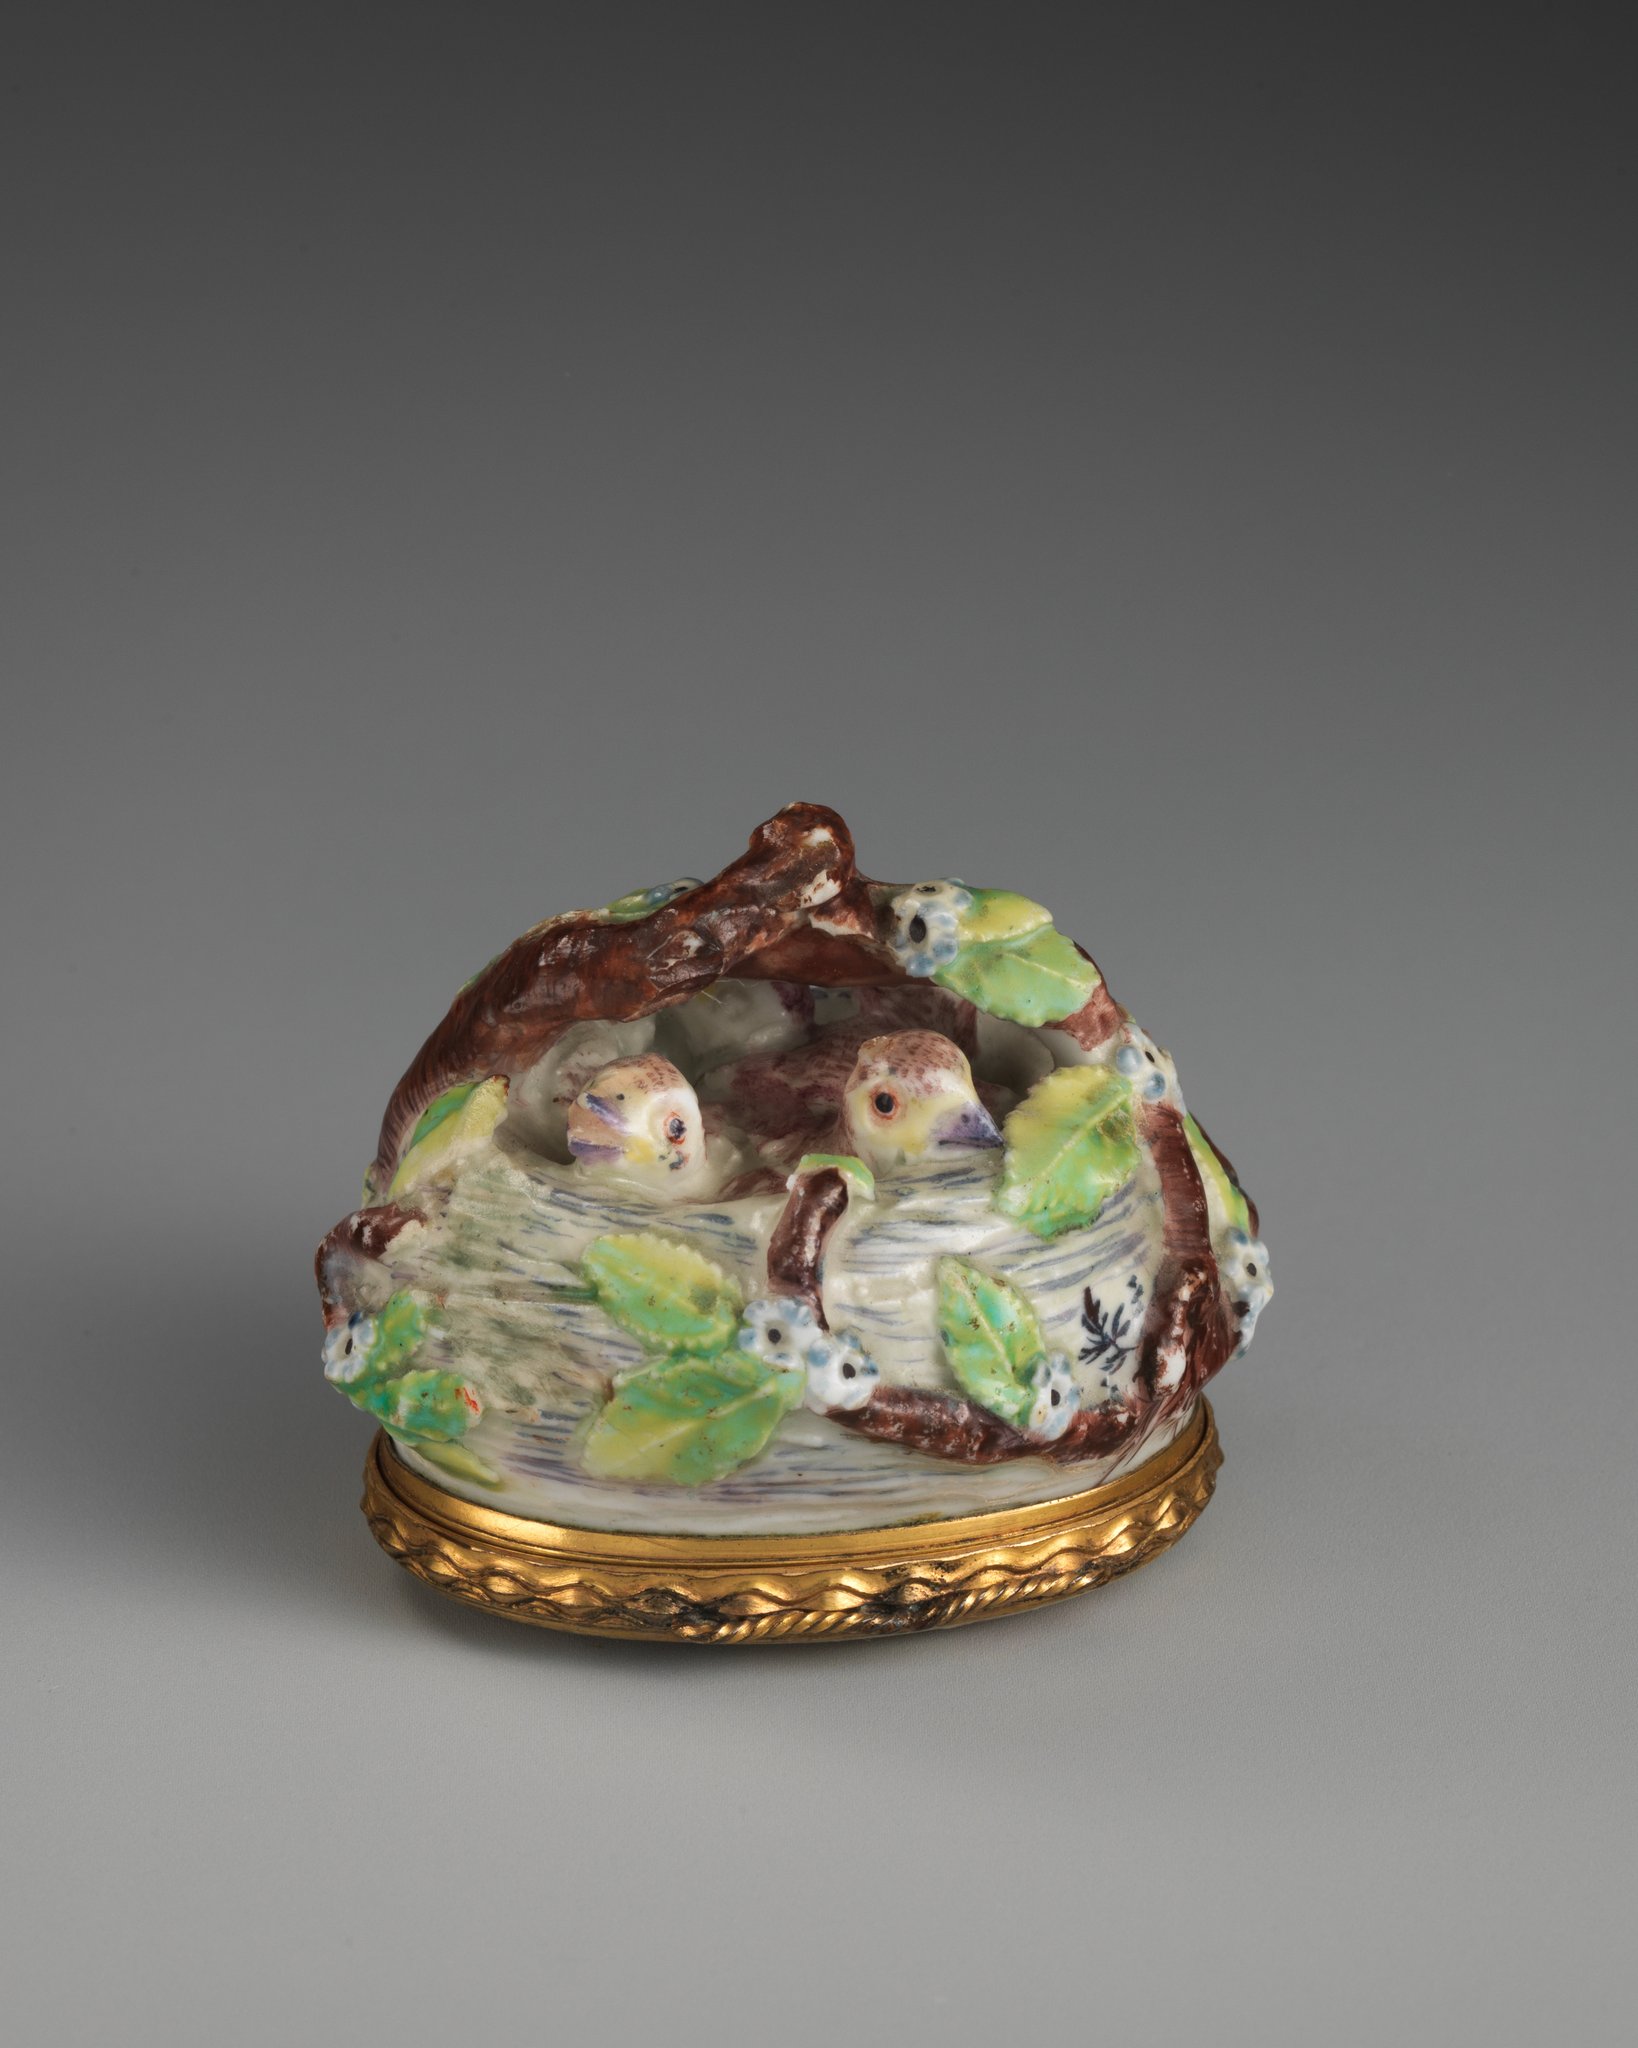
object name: toy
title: Bird's nest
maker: chelsea porcelain manufactory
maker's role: factory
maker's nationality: british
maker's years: 1744-1784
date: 1755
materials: soft paste porcelain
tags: birds,leaves